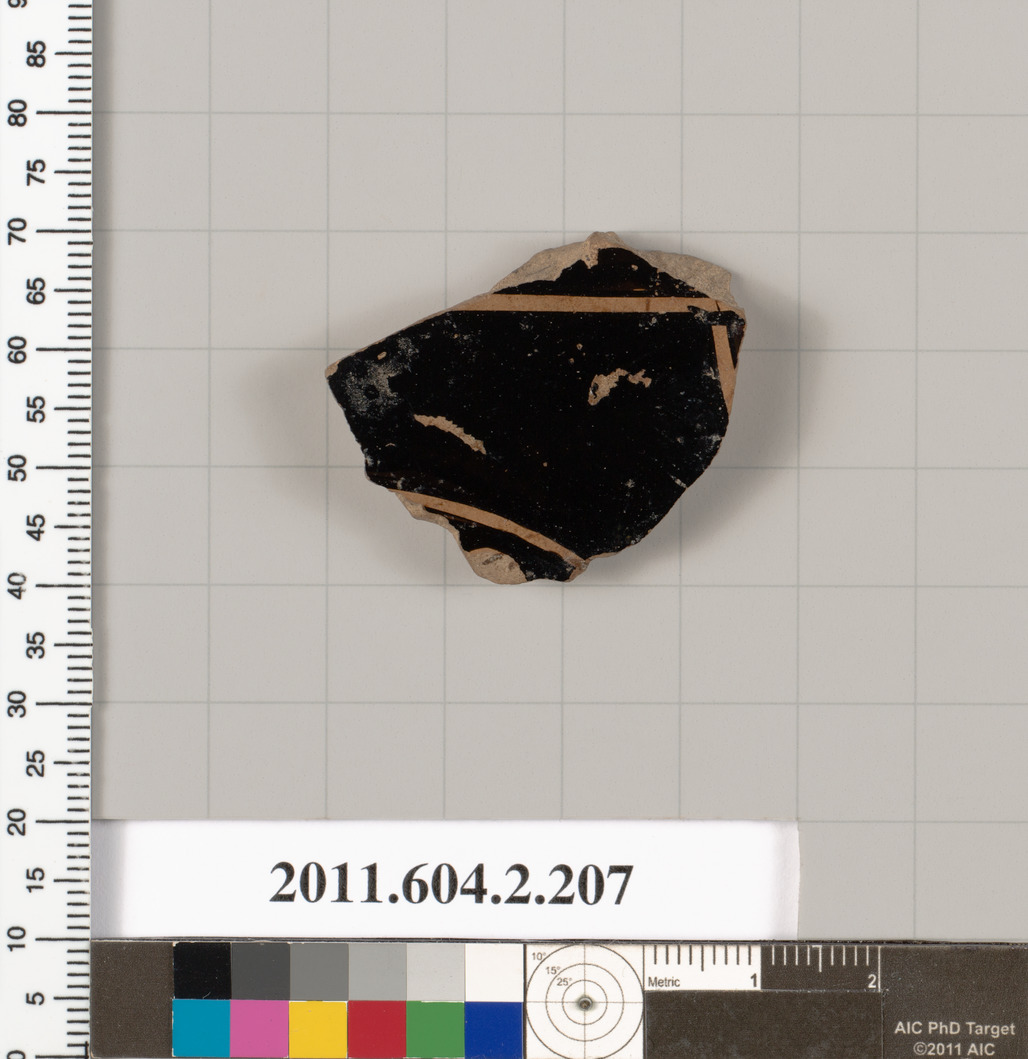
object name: stamnos fragment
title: Terracotta fragment of a stamnos (jar)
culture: greek, attic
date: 520-490 BCE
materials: terracotta